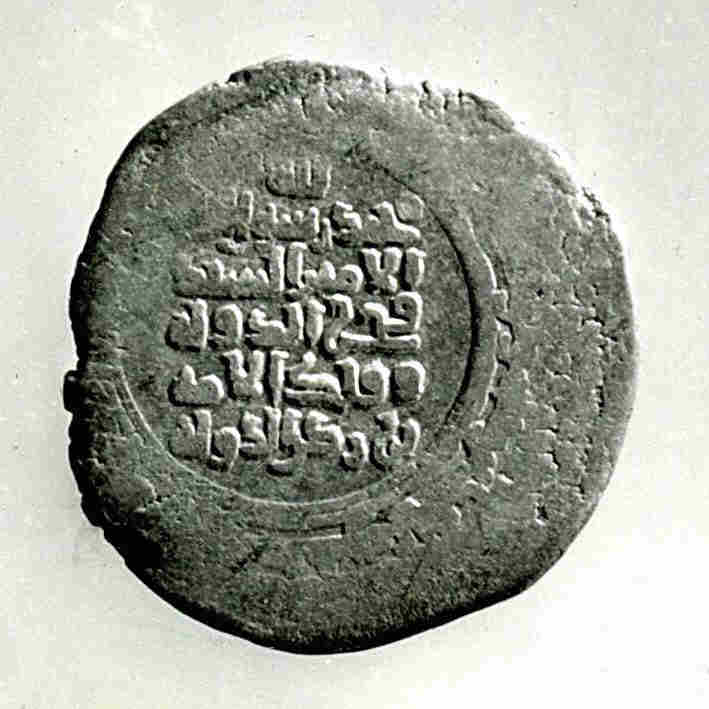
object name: coin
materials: silver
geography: iran